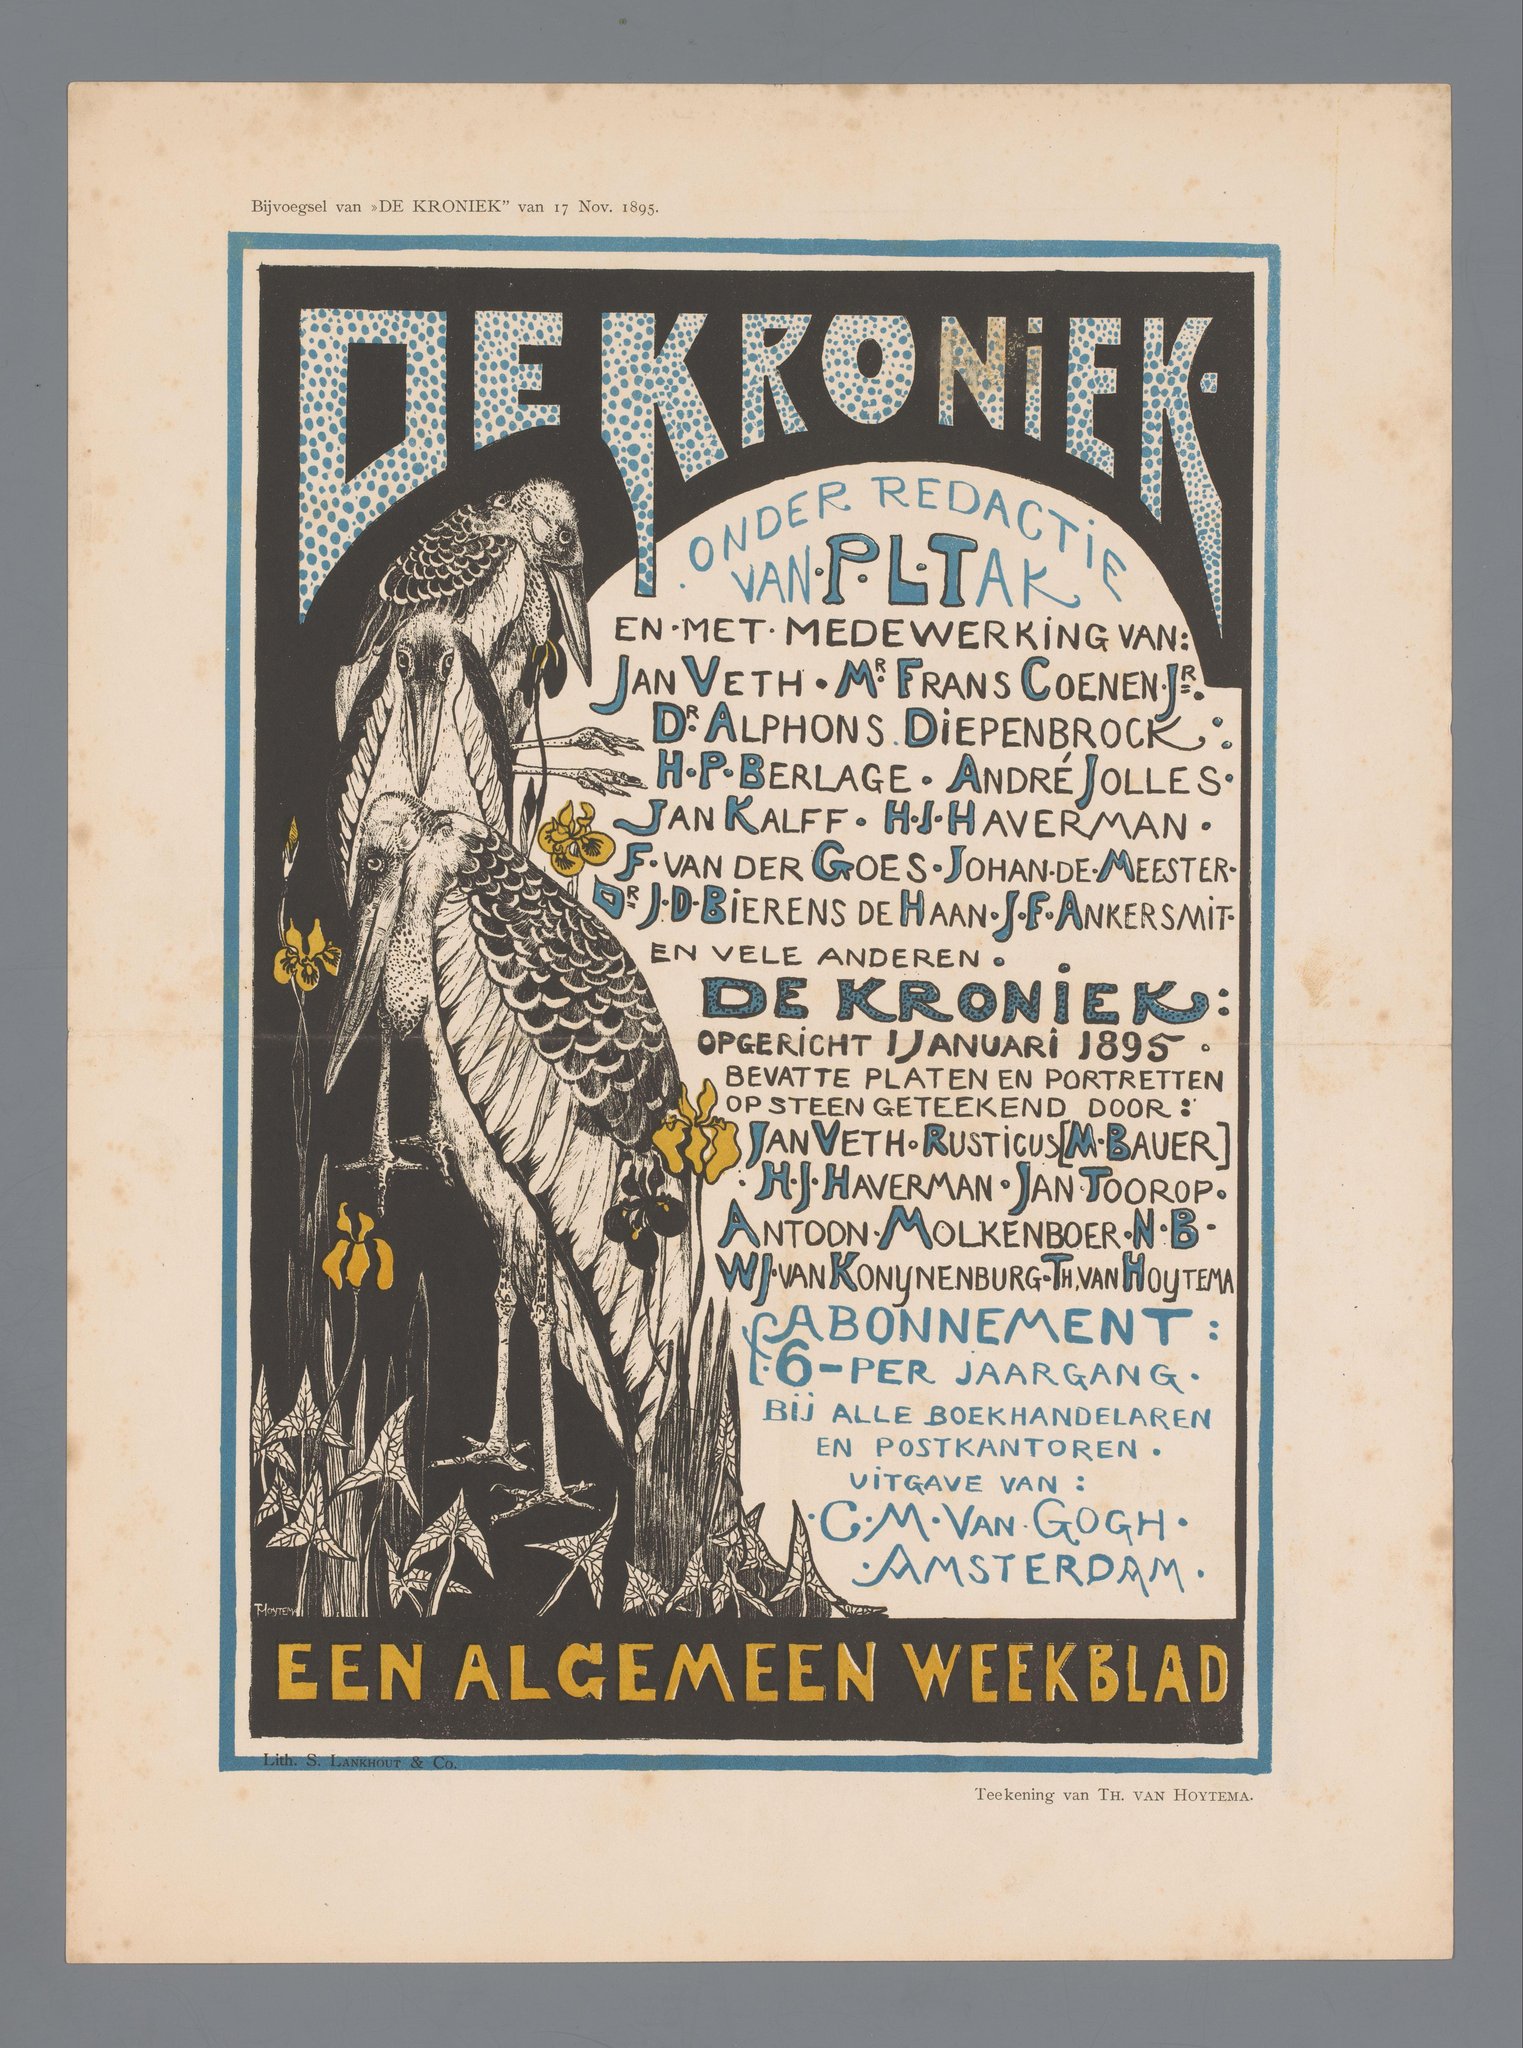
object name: print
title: De Kroniek / Een Algemeen Weekblad / onder redactie van P.L. Tak en met medewerking van (...)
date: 1895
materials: paper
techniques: lithograph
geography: amsterdam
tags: shore-birds and wading-birds: marabou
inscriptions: signature and date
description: Colofon met de namen van de medewerkers bij 'De Kroniek'. Links drie waadvogels, mogelijk maraboes. Bijvoegsel van De Kroniek van 17 november 1895.